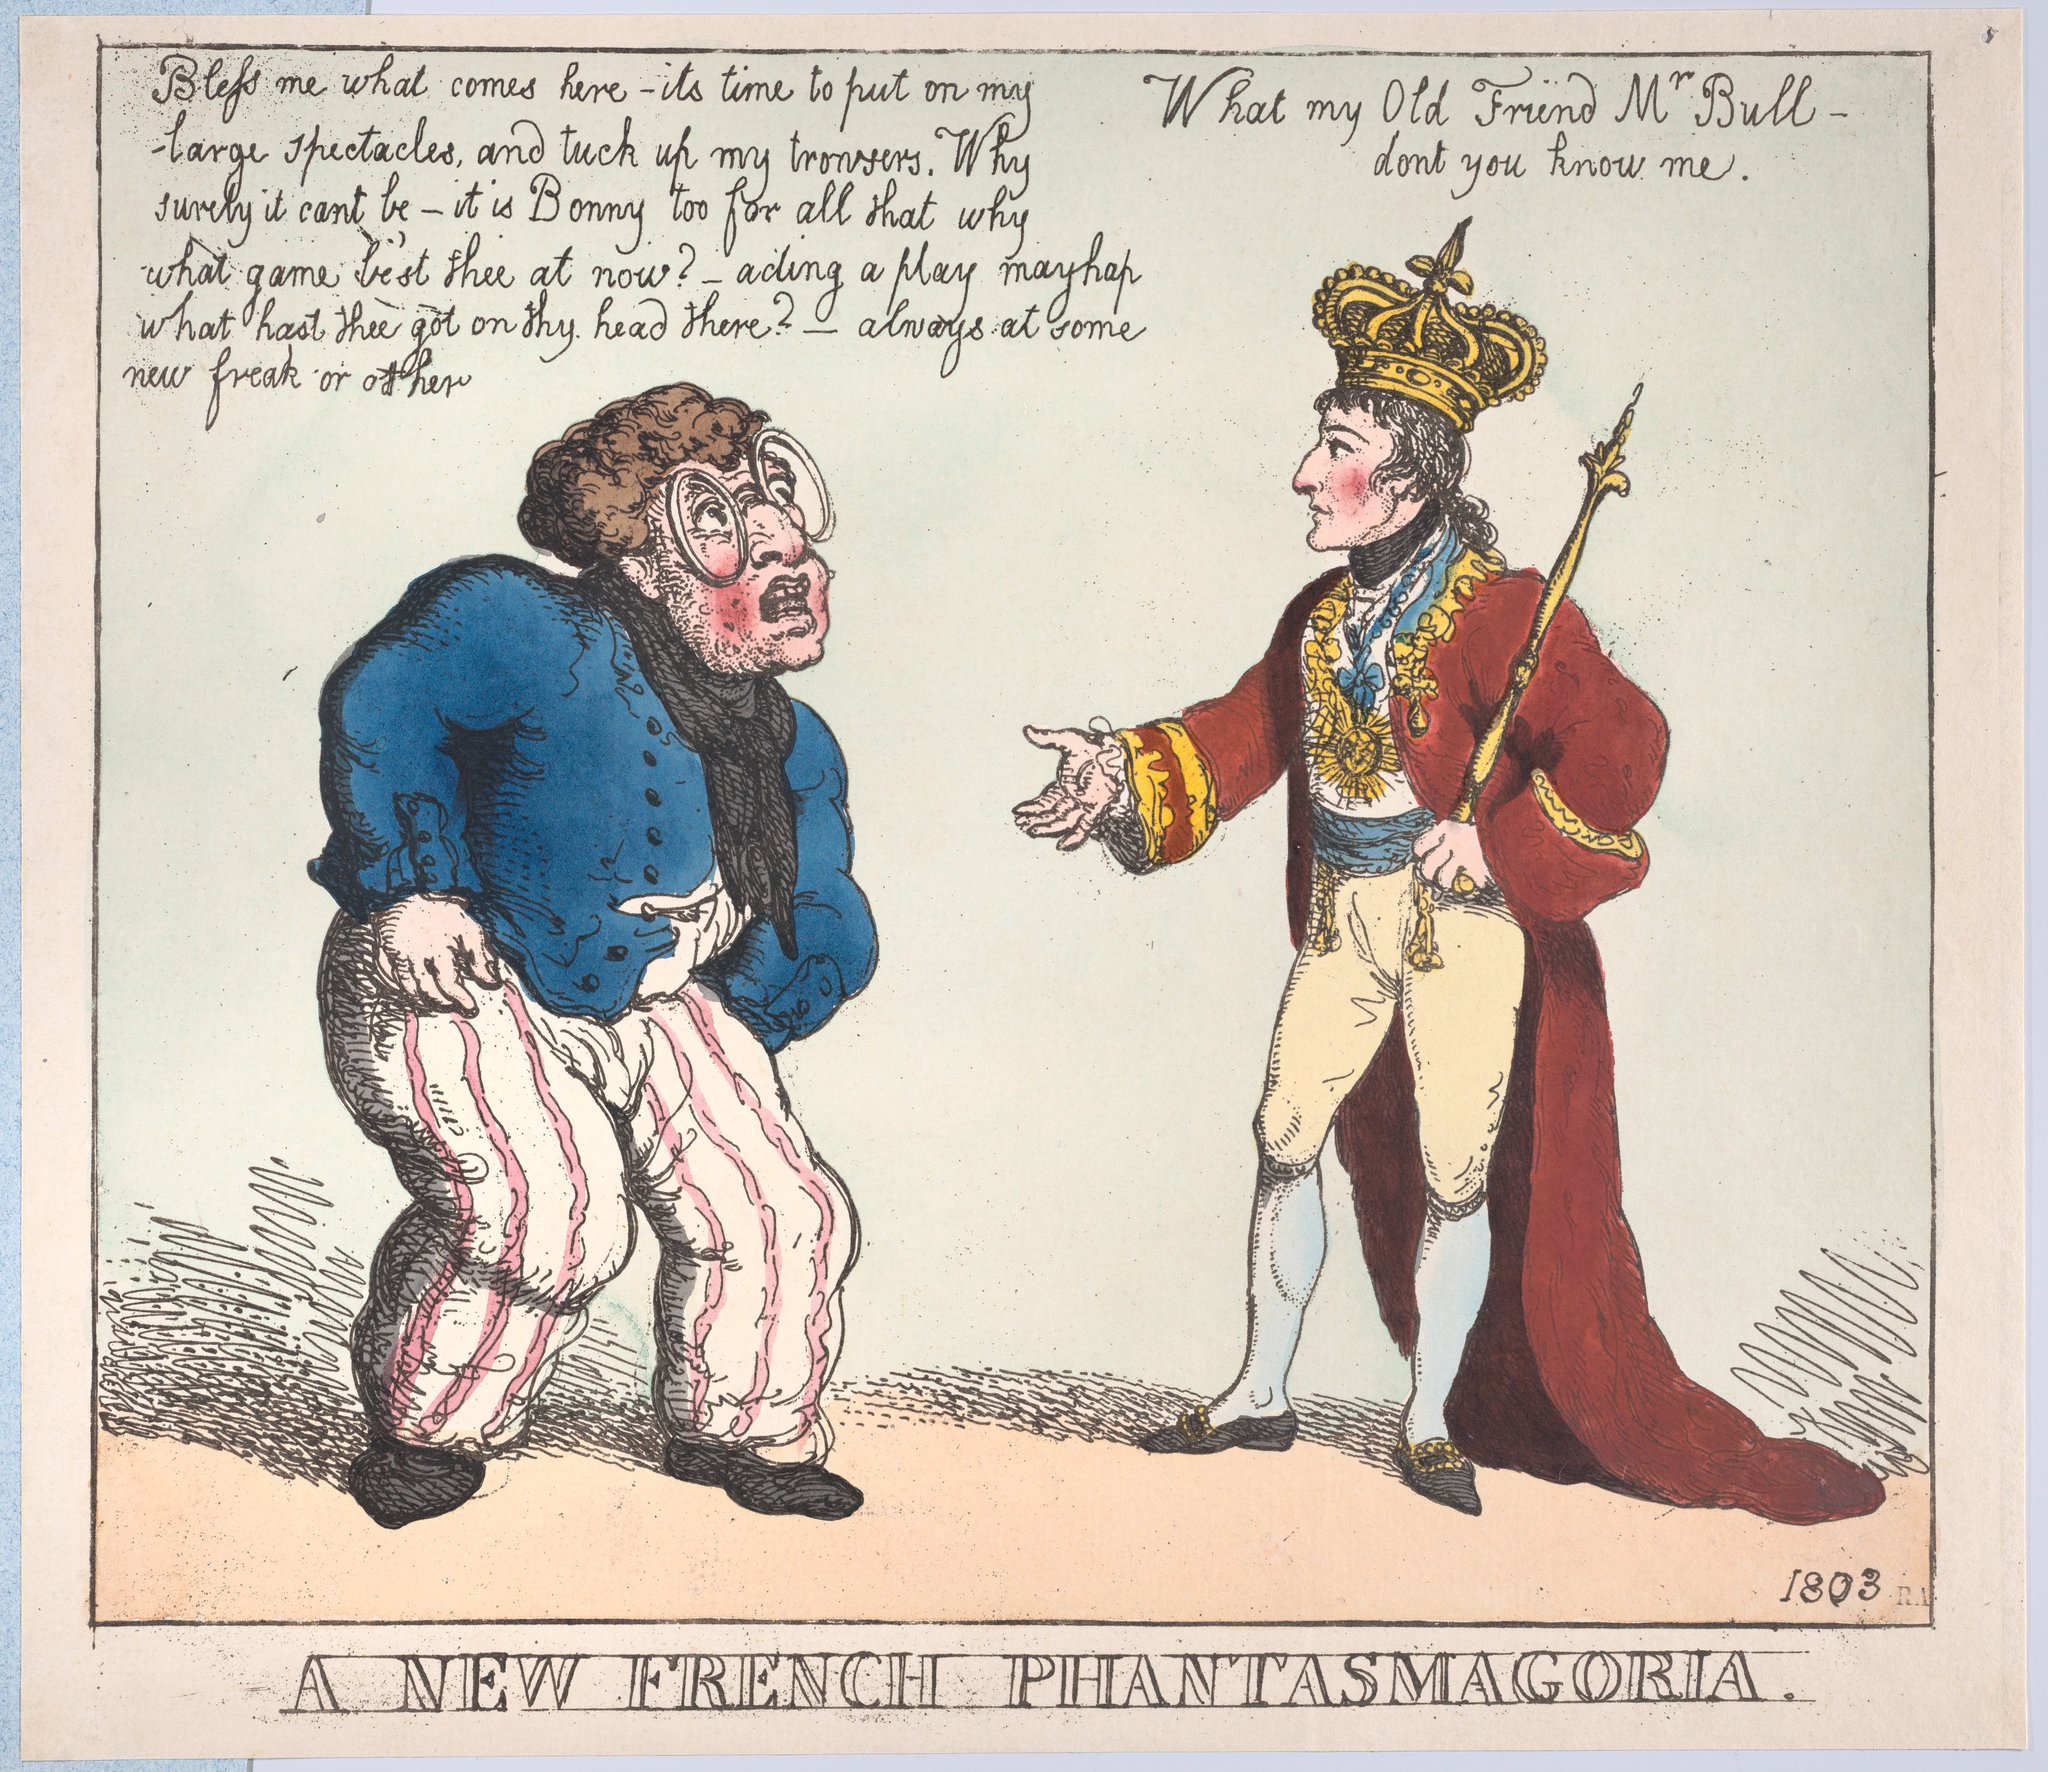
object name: print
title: A New French Phantasmagoria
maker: thomas rowlandson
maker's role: artist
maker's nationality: british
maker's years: 1757-1827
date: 1803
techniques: etching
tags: satire,napoleon i,men,politics